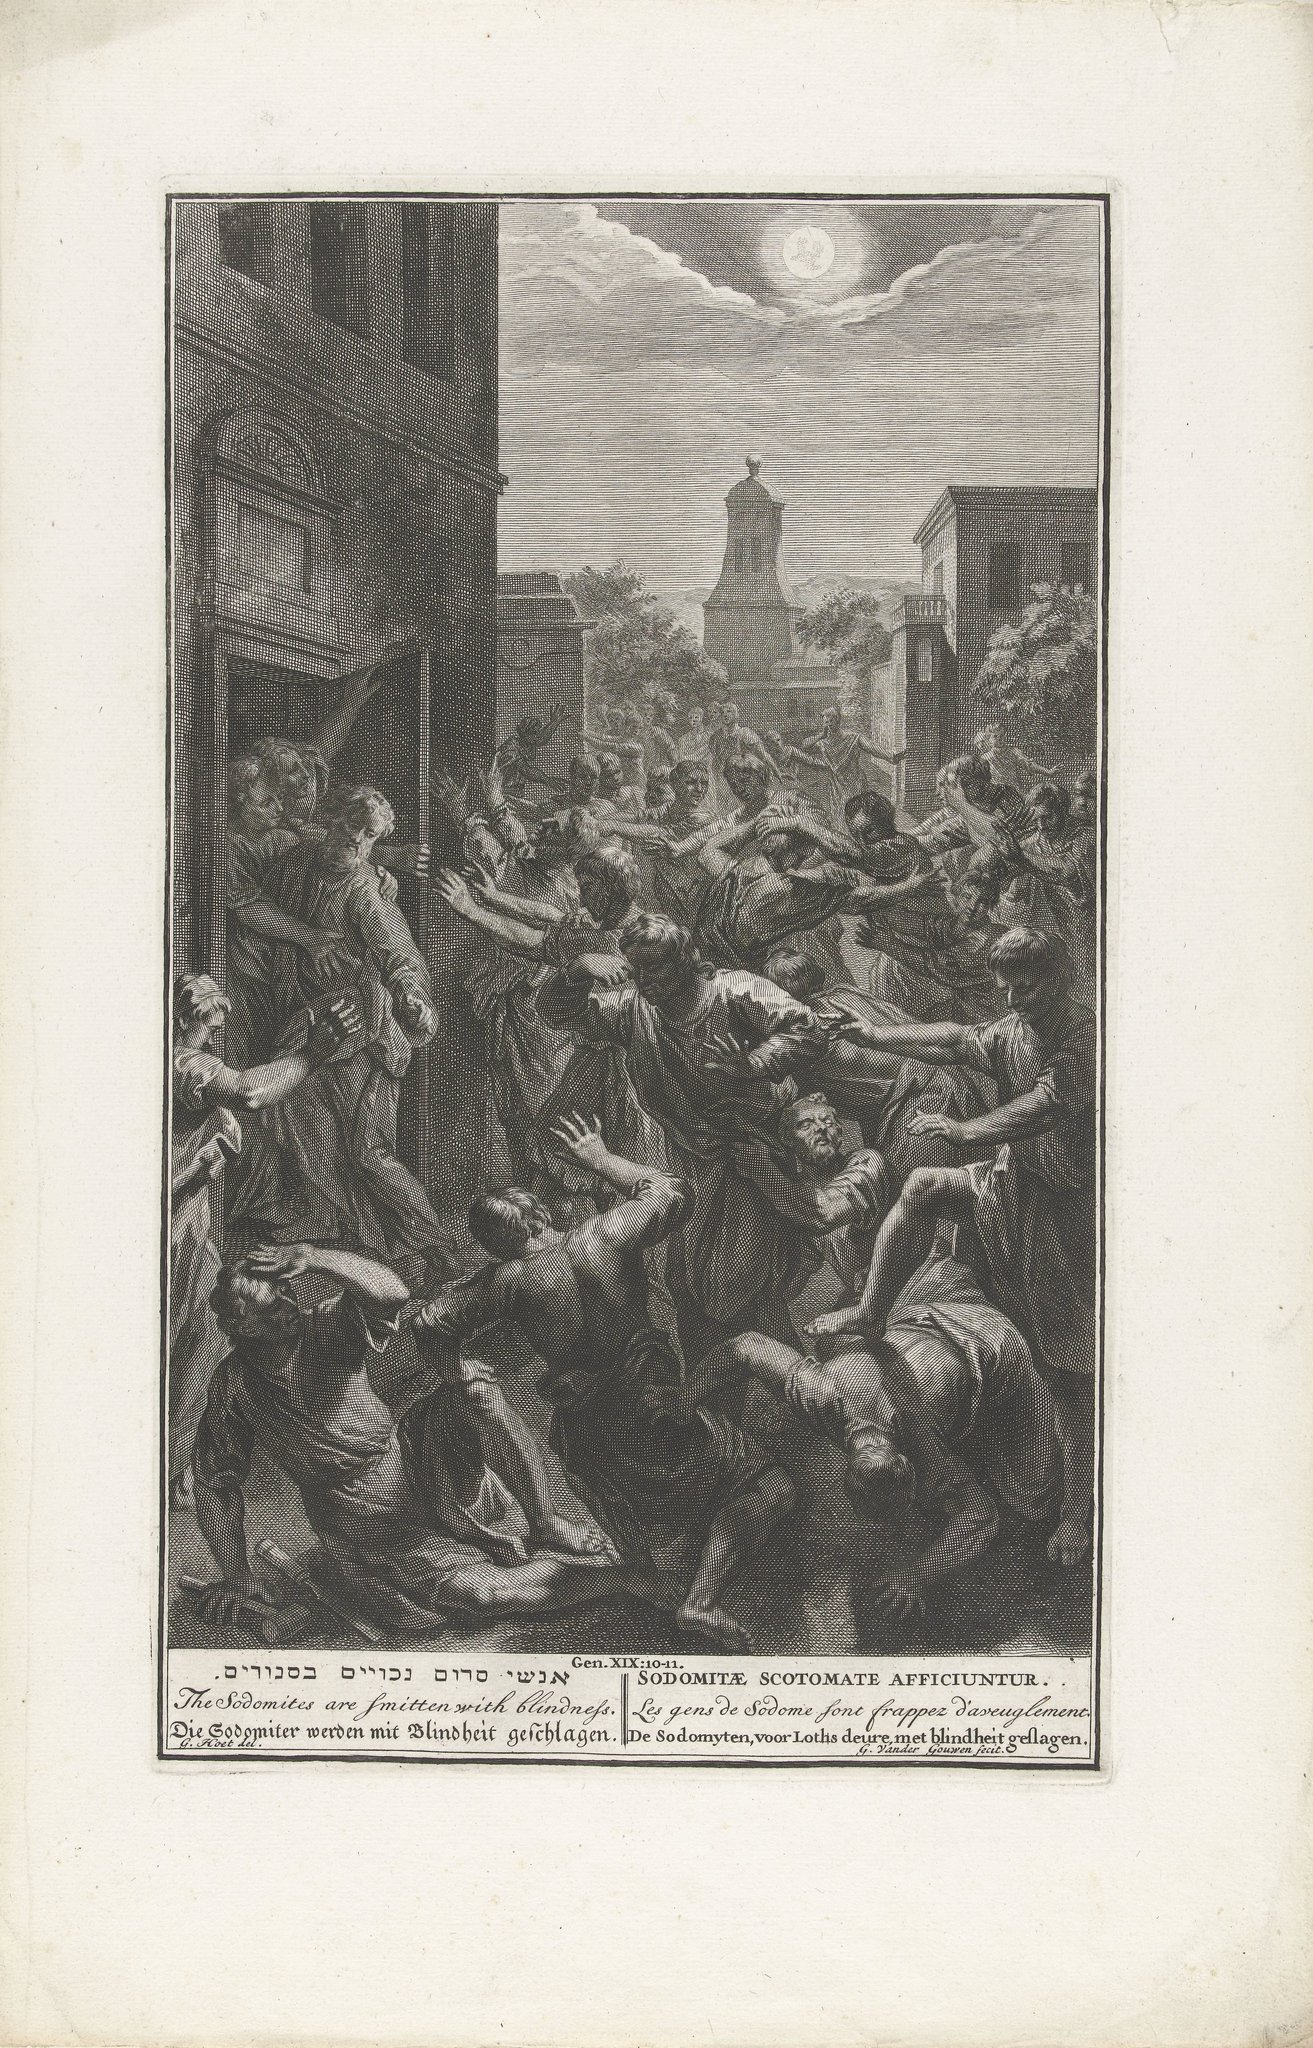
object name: print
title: Sodomieten met blindheid geslagen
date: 1728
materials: paper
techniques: engraving, etching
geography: the hague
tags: the two angels intervene and strike the mob that surround lot's house with blindness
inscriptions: inscription: ‘utrechts Fundatie huijs’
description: Twee engelen worden door de inwoners van Sodom aangevallen. De Sodomieten worden met blindheid geslagen (Gen. 19:10-11). De prent heeft een Hebreeuws, Latijns, Frans, Engels, Duits en Nederlands onderschrift.